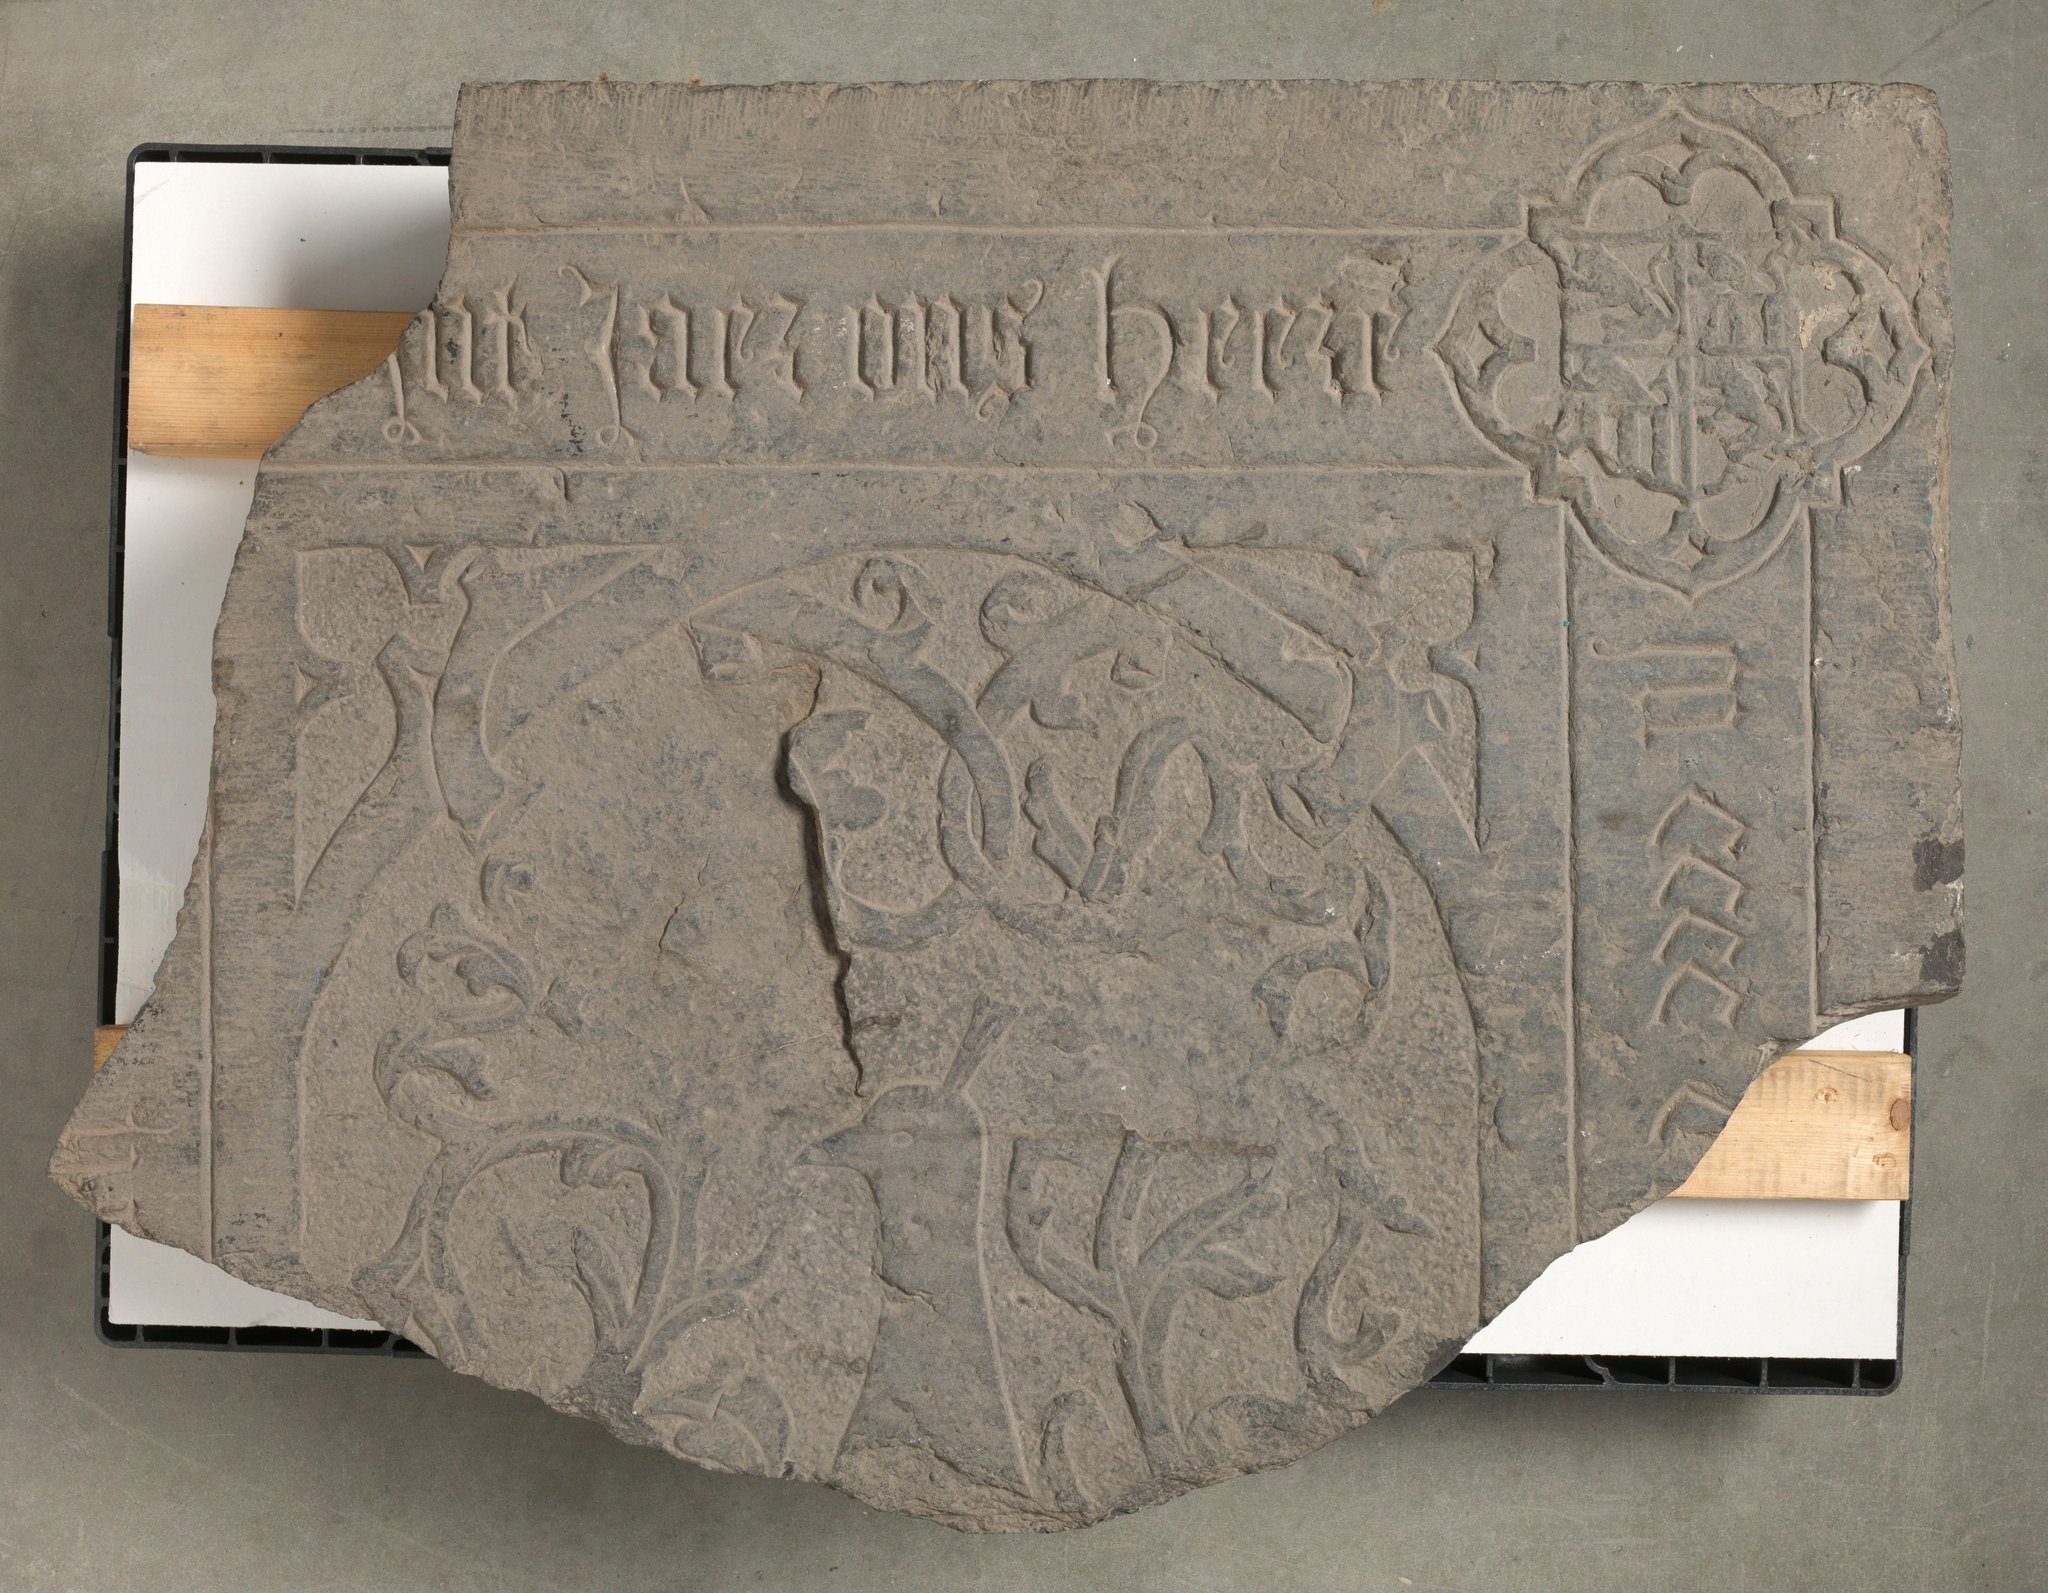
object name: grafzerk, zerk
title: Fragment van een grafzerk met beeldhouwwerk en jaartal MCCCC.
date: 1497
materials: stone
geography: berne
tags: bern (gelderland)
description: Fragment van de rechterbovenhoek van de grafzerk van Arent van Malsen. Het fragment heeft een rondschrift: INT JAER ONS HEERE/ MCCCC, in de rechterhoek een wapen en in het middenveld een kop van een pauw binnen bladranken. Het fragment hoort bij zeven fragmenten van een incomplete grafzerk (BK-NM-8657-B-1 t/m BK-NM-8657-B-8).